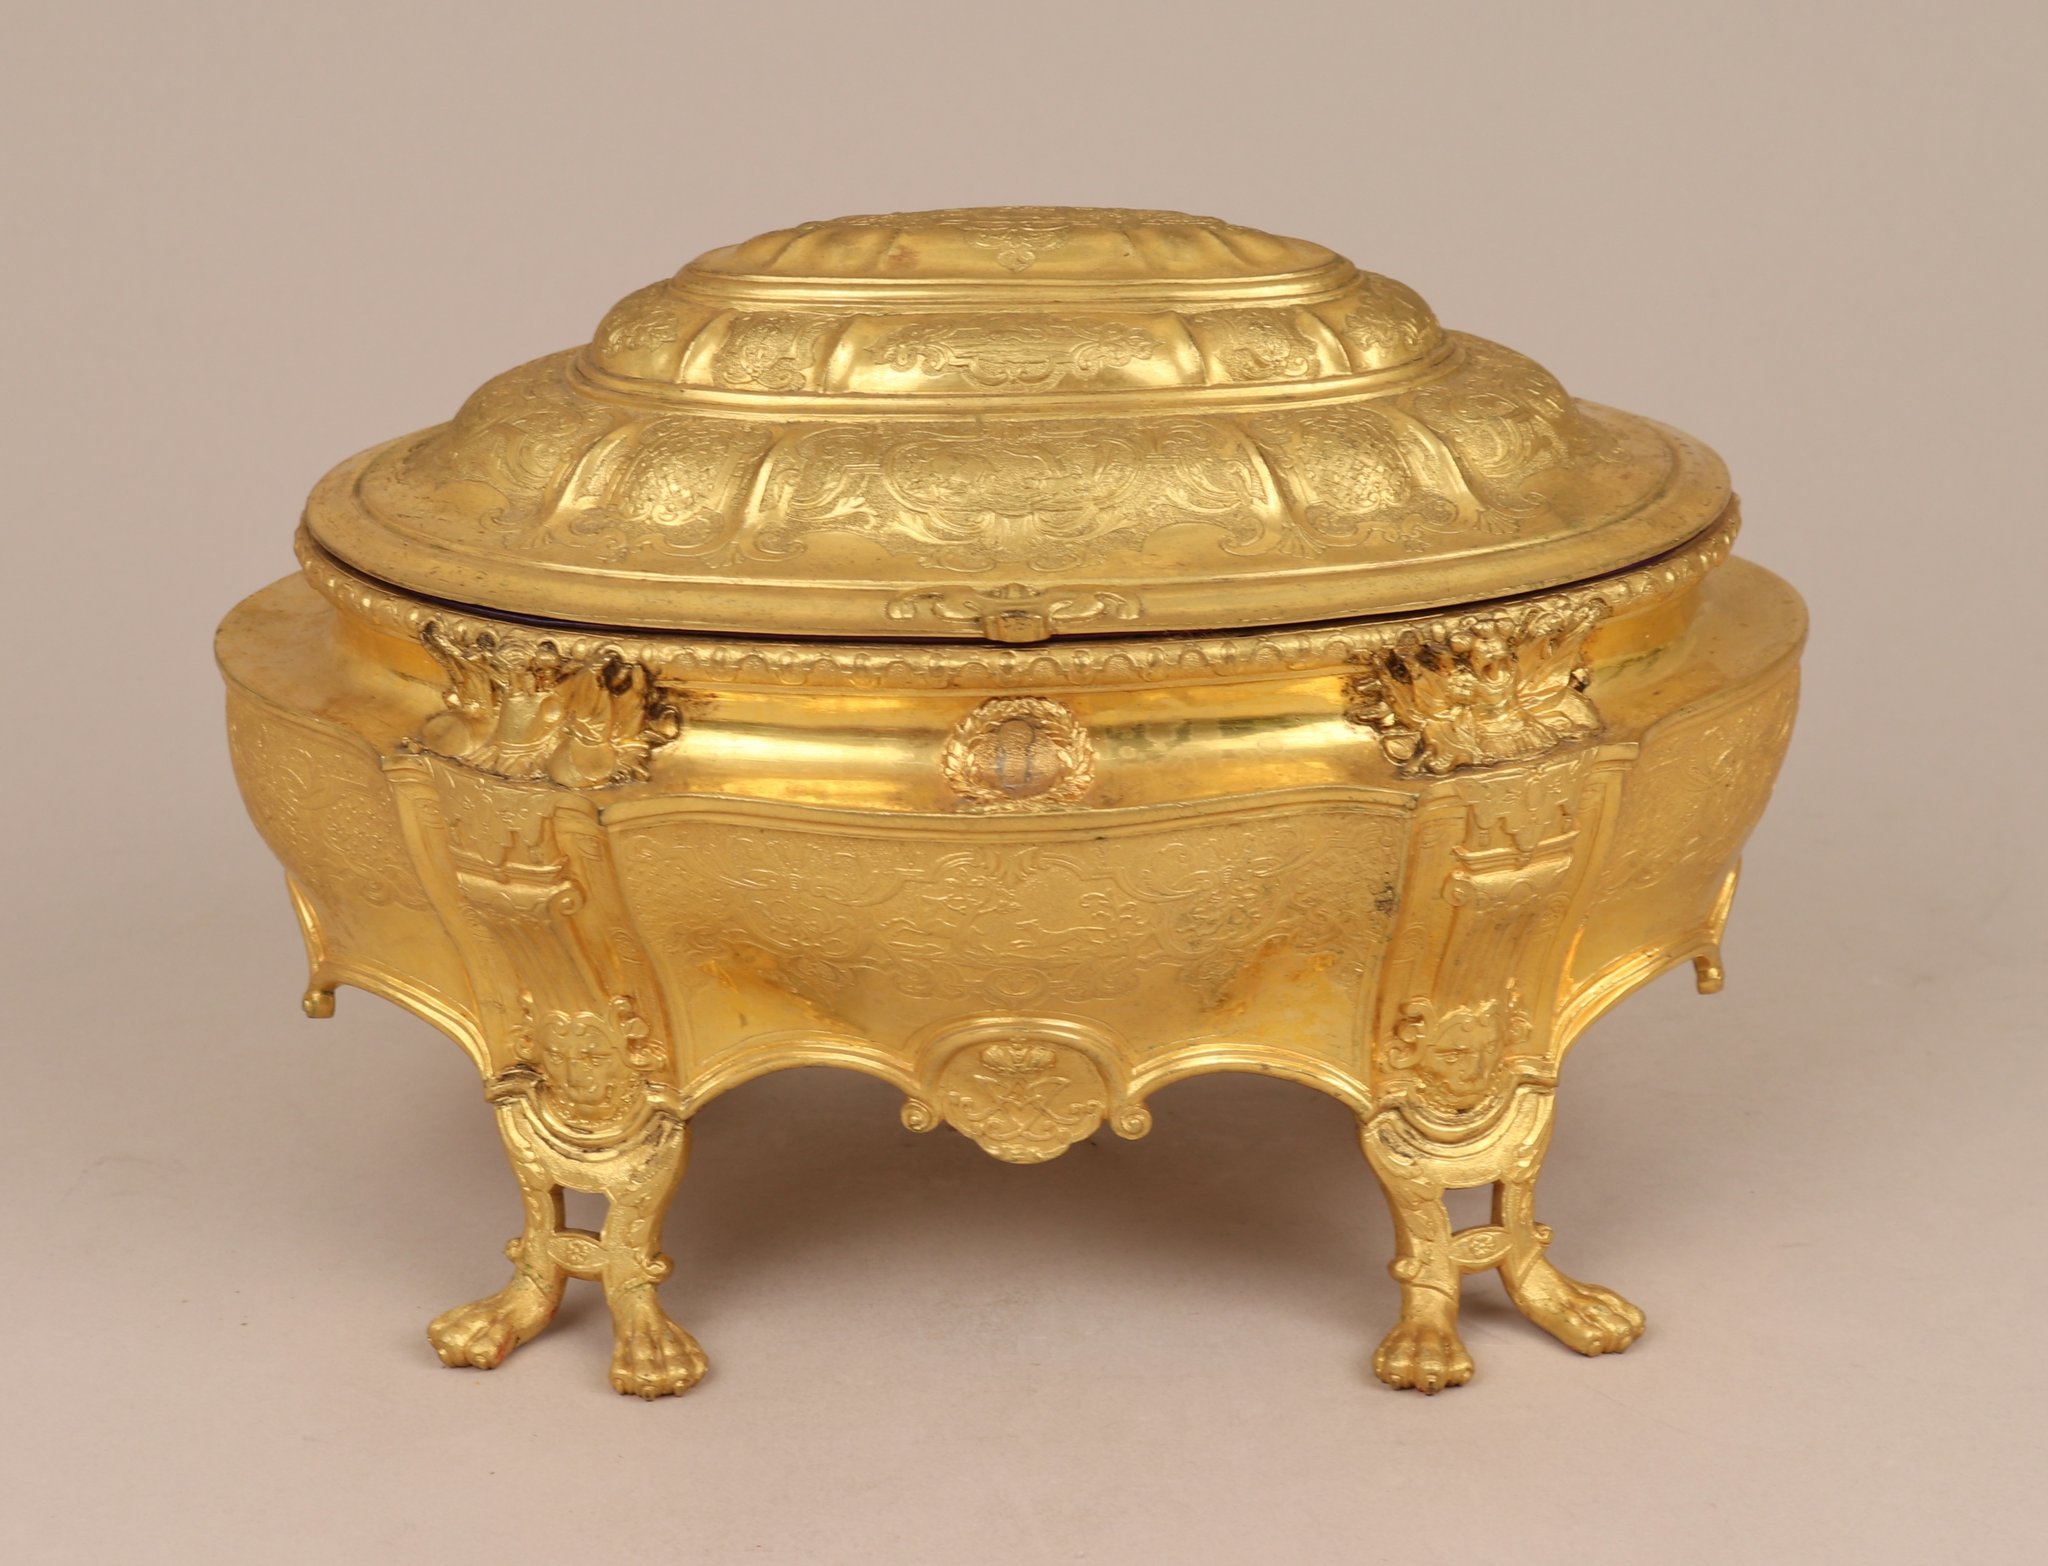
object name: casket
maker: johann ludwig ii biller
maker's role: maker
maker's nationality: german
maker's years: 1692-1746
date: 1801-1900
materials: gold